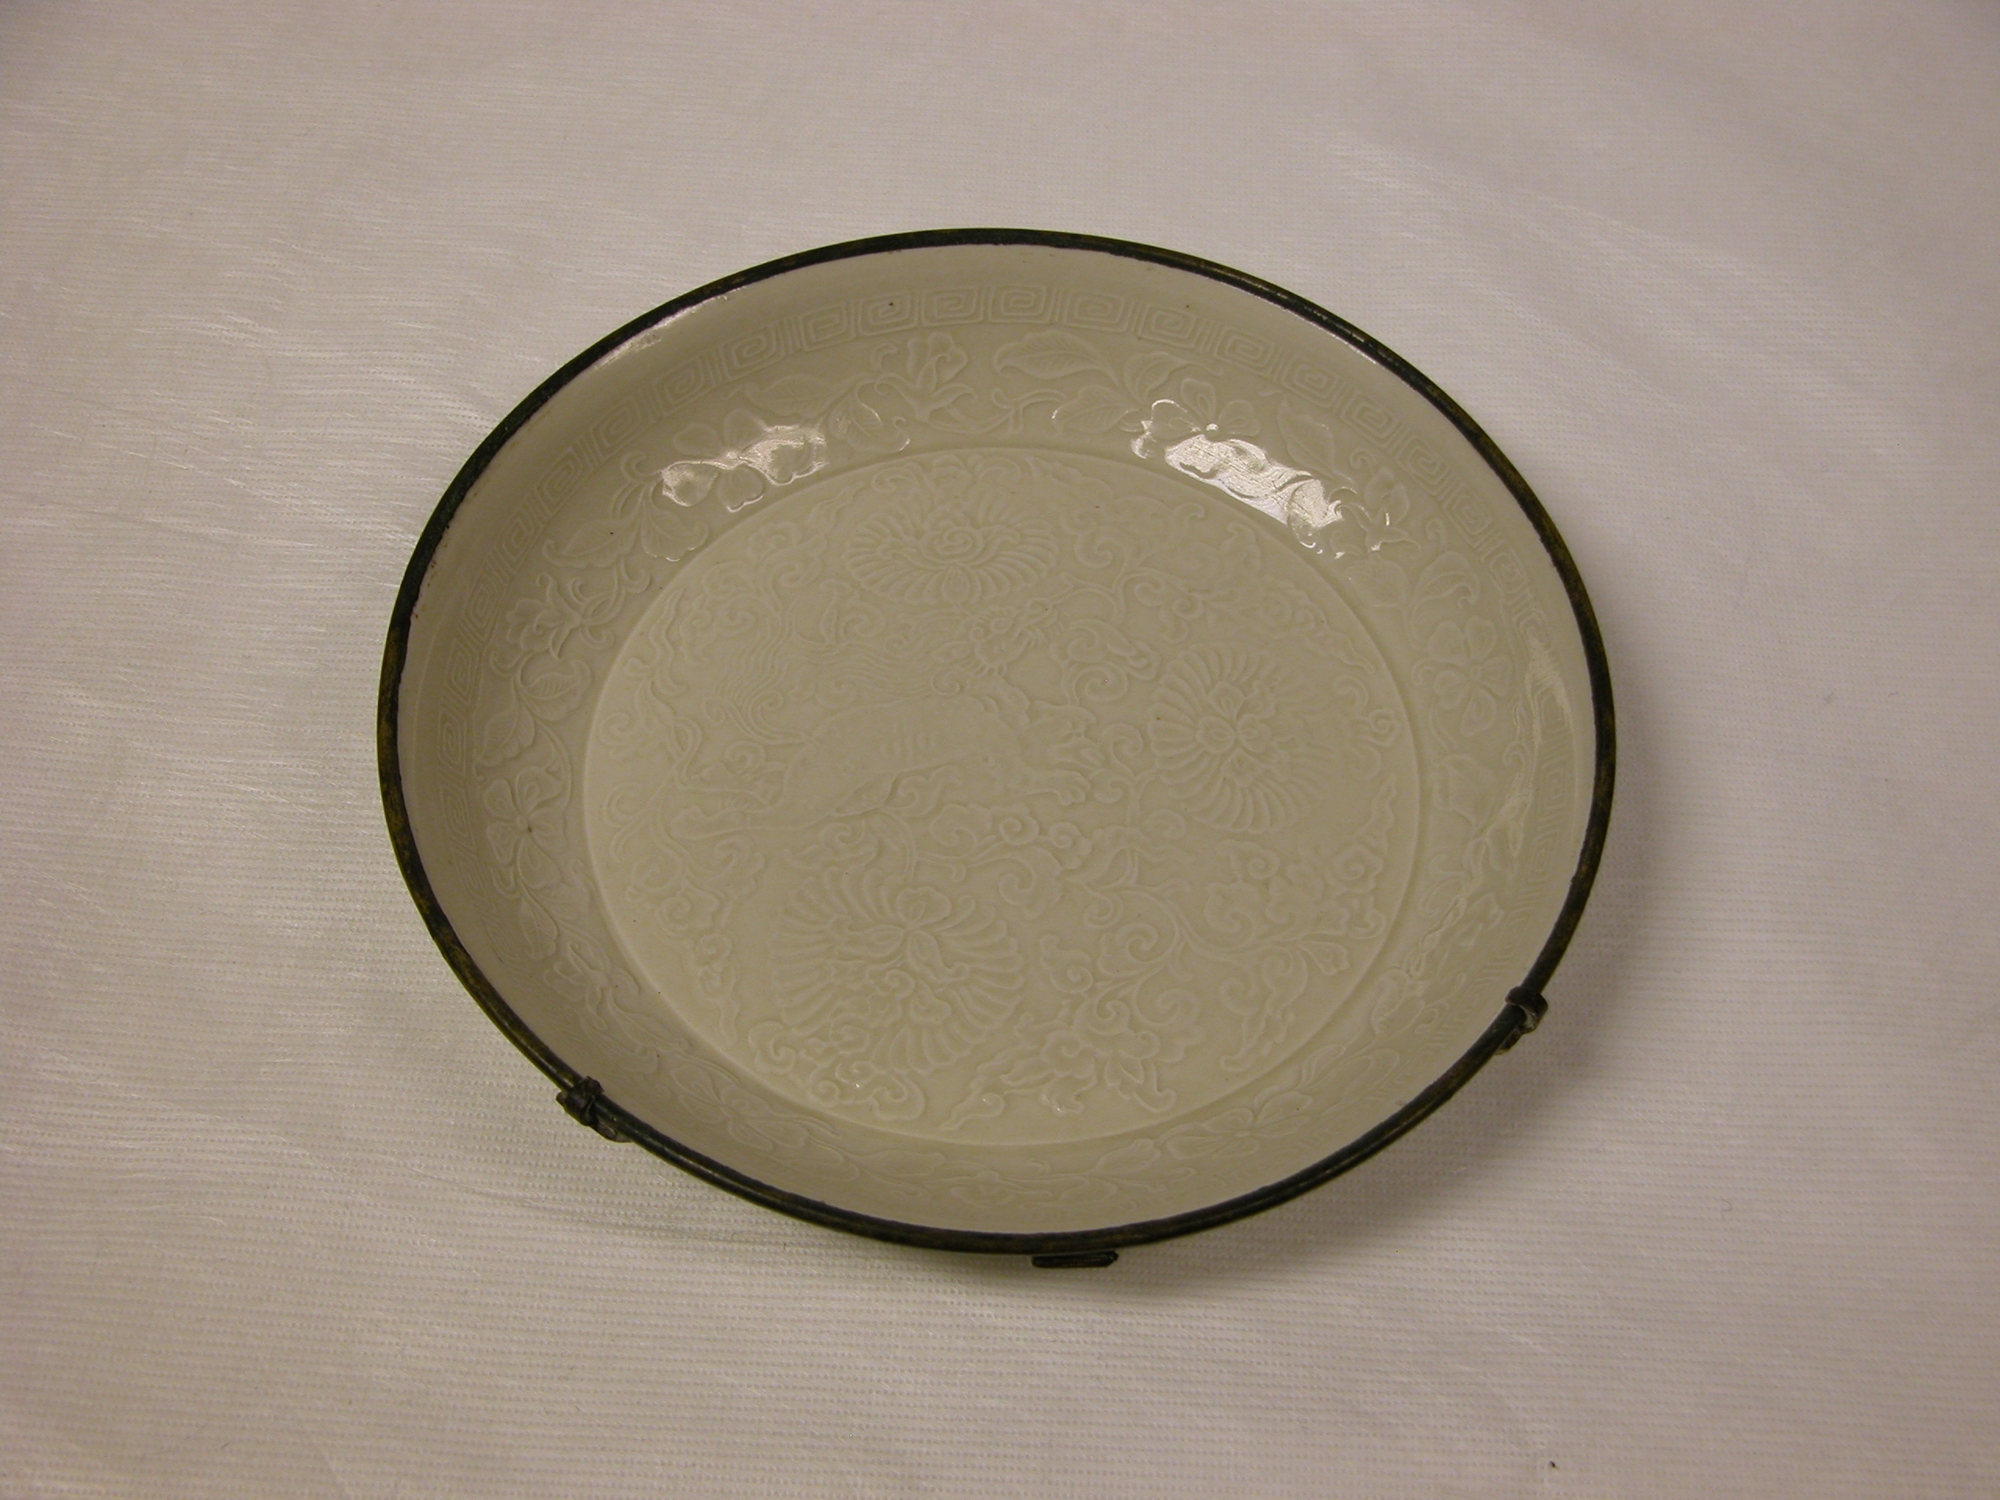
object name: dish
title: Dish with Lion among Chrysanthemums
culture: chinese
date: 1101-1300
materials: glaze, ivory, porcelain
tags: lions,flowers